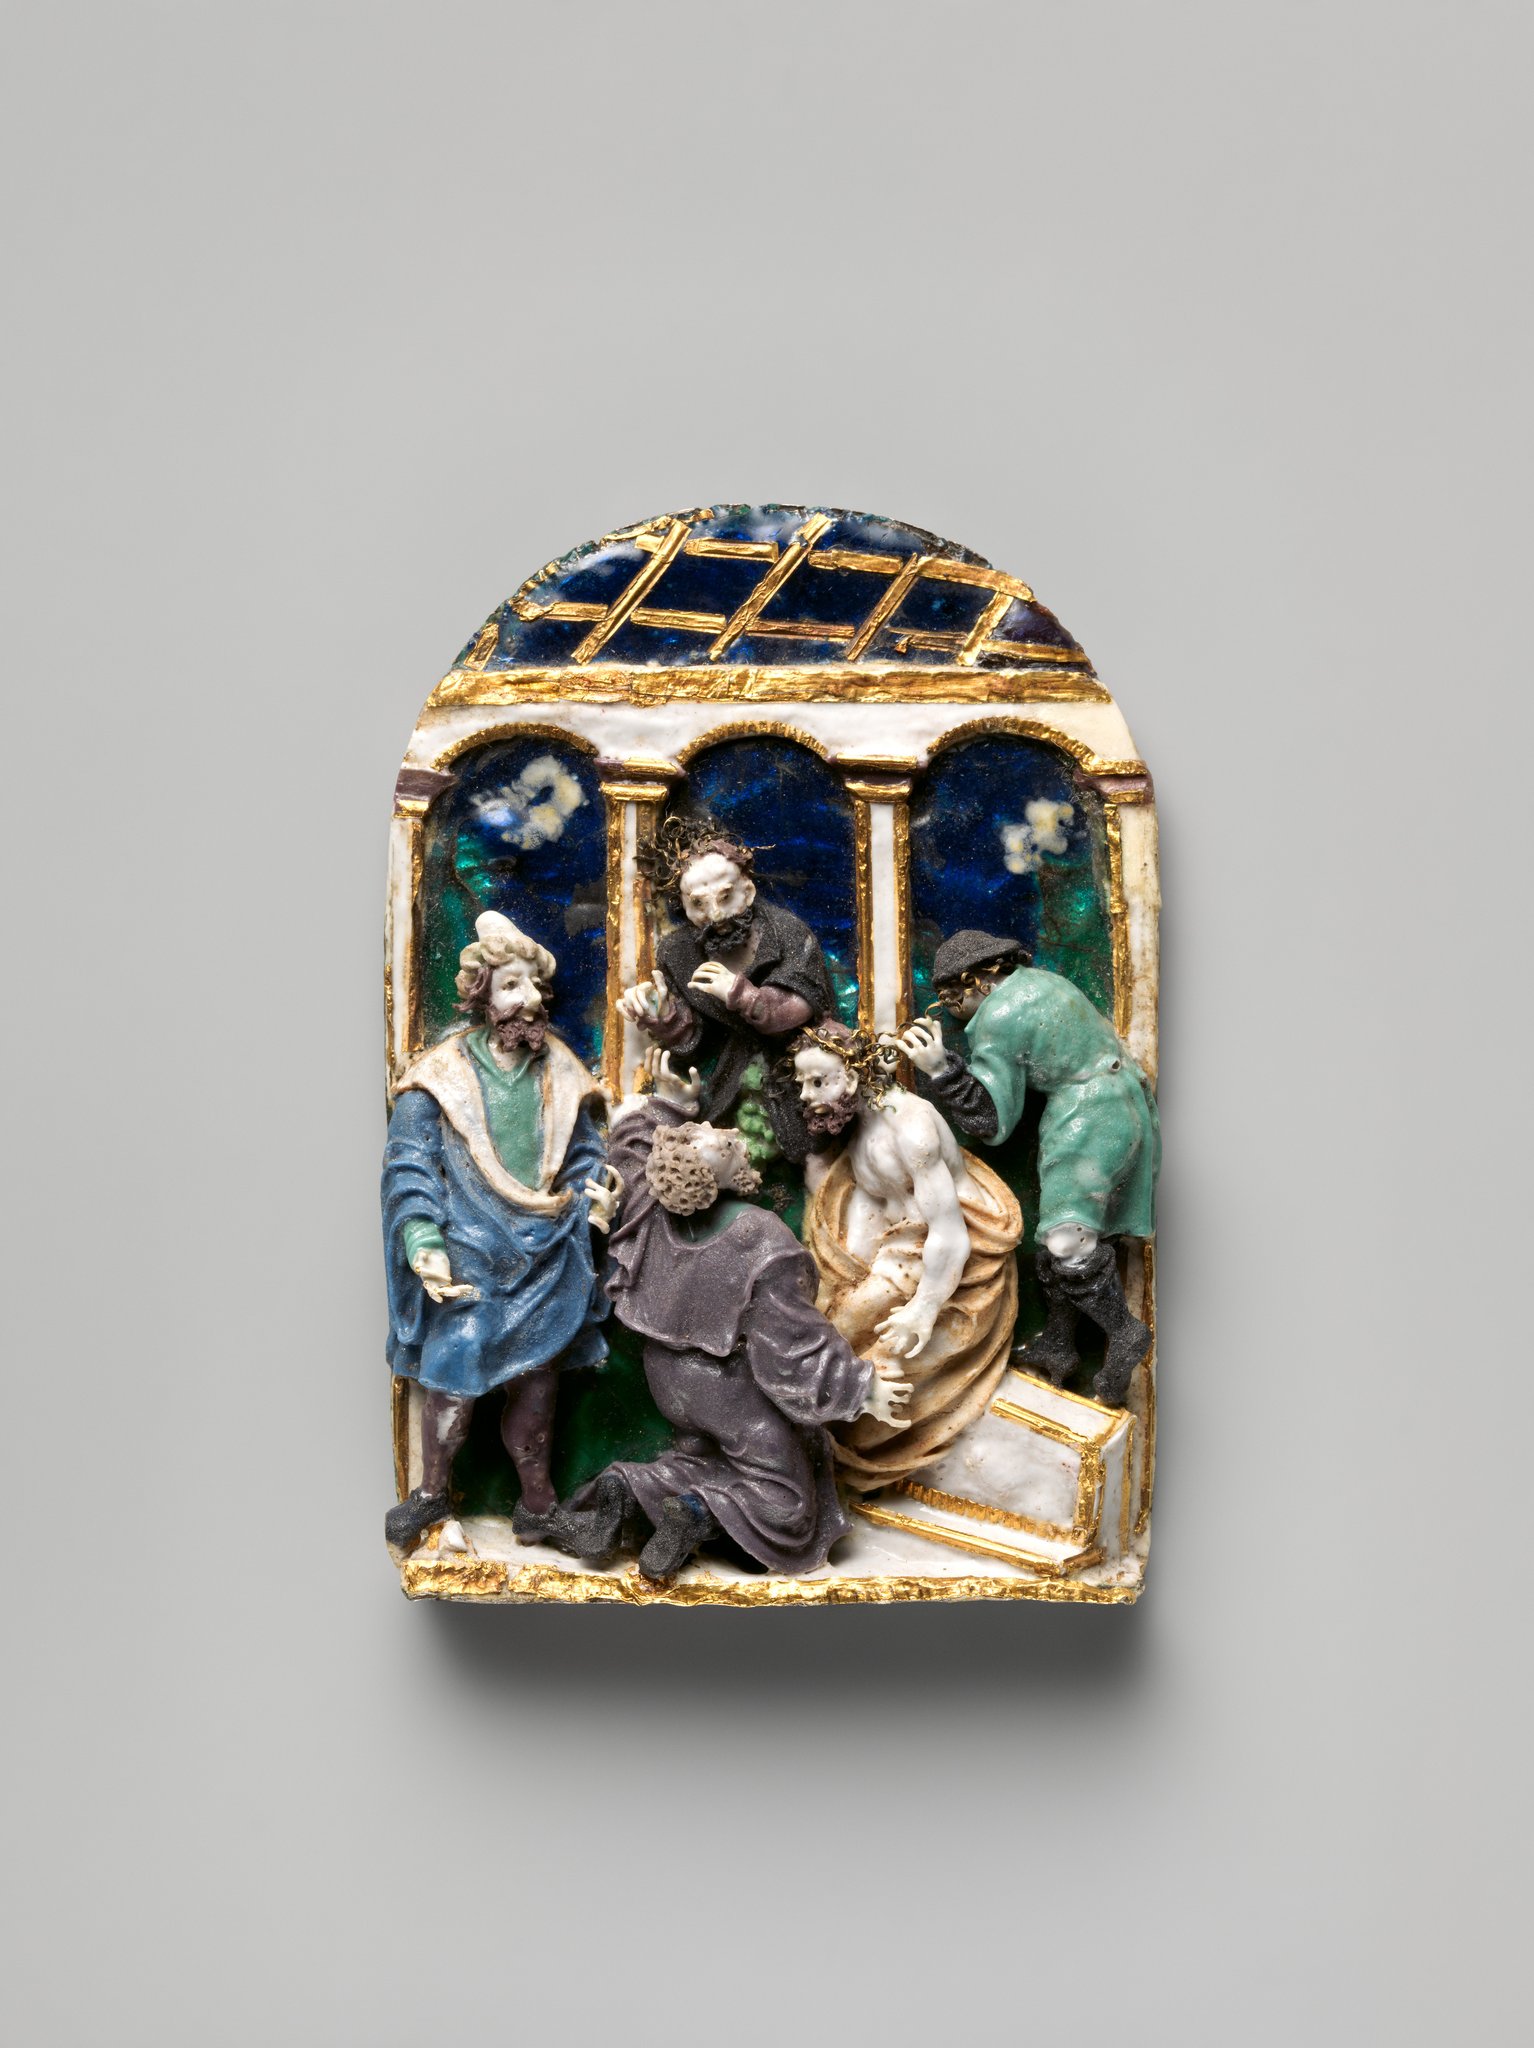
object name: plaquette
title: Crowning with Thorns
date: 1520-1530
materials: enamel, glass, gold, silver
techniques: lampwork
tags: men,christ